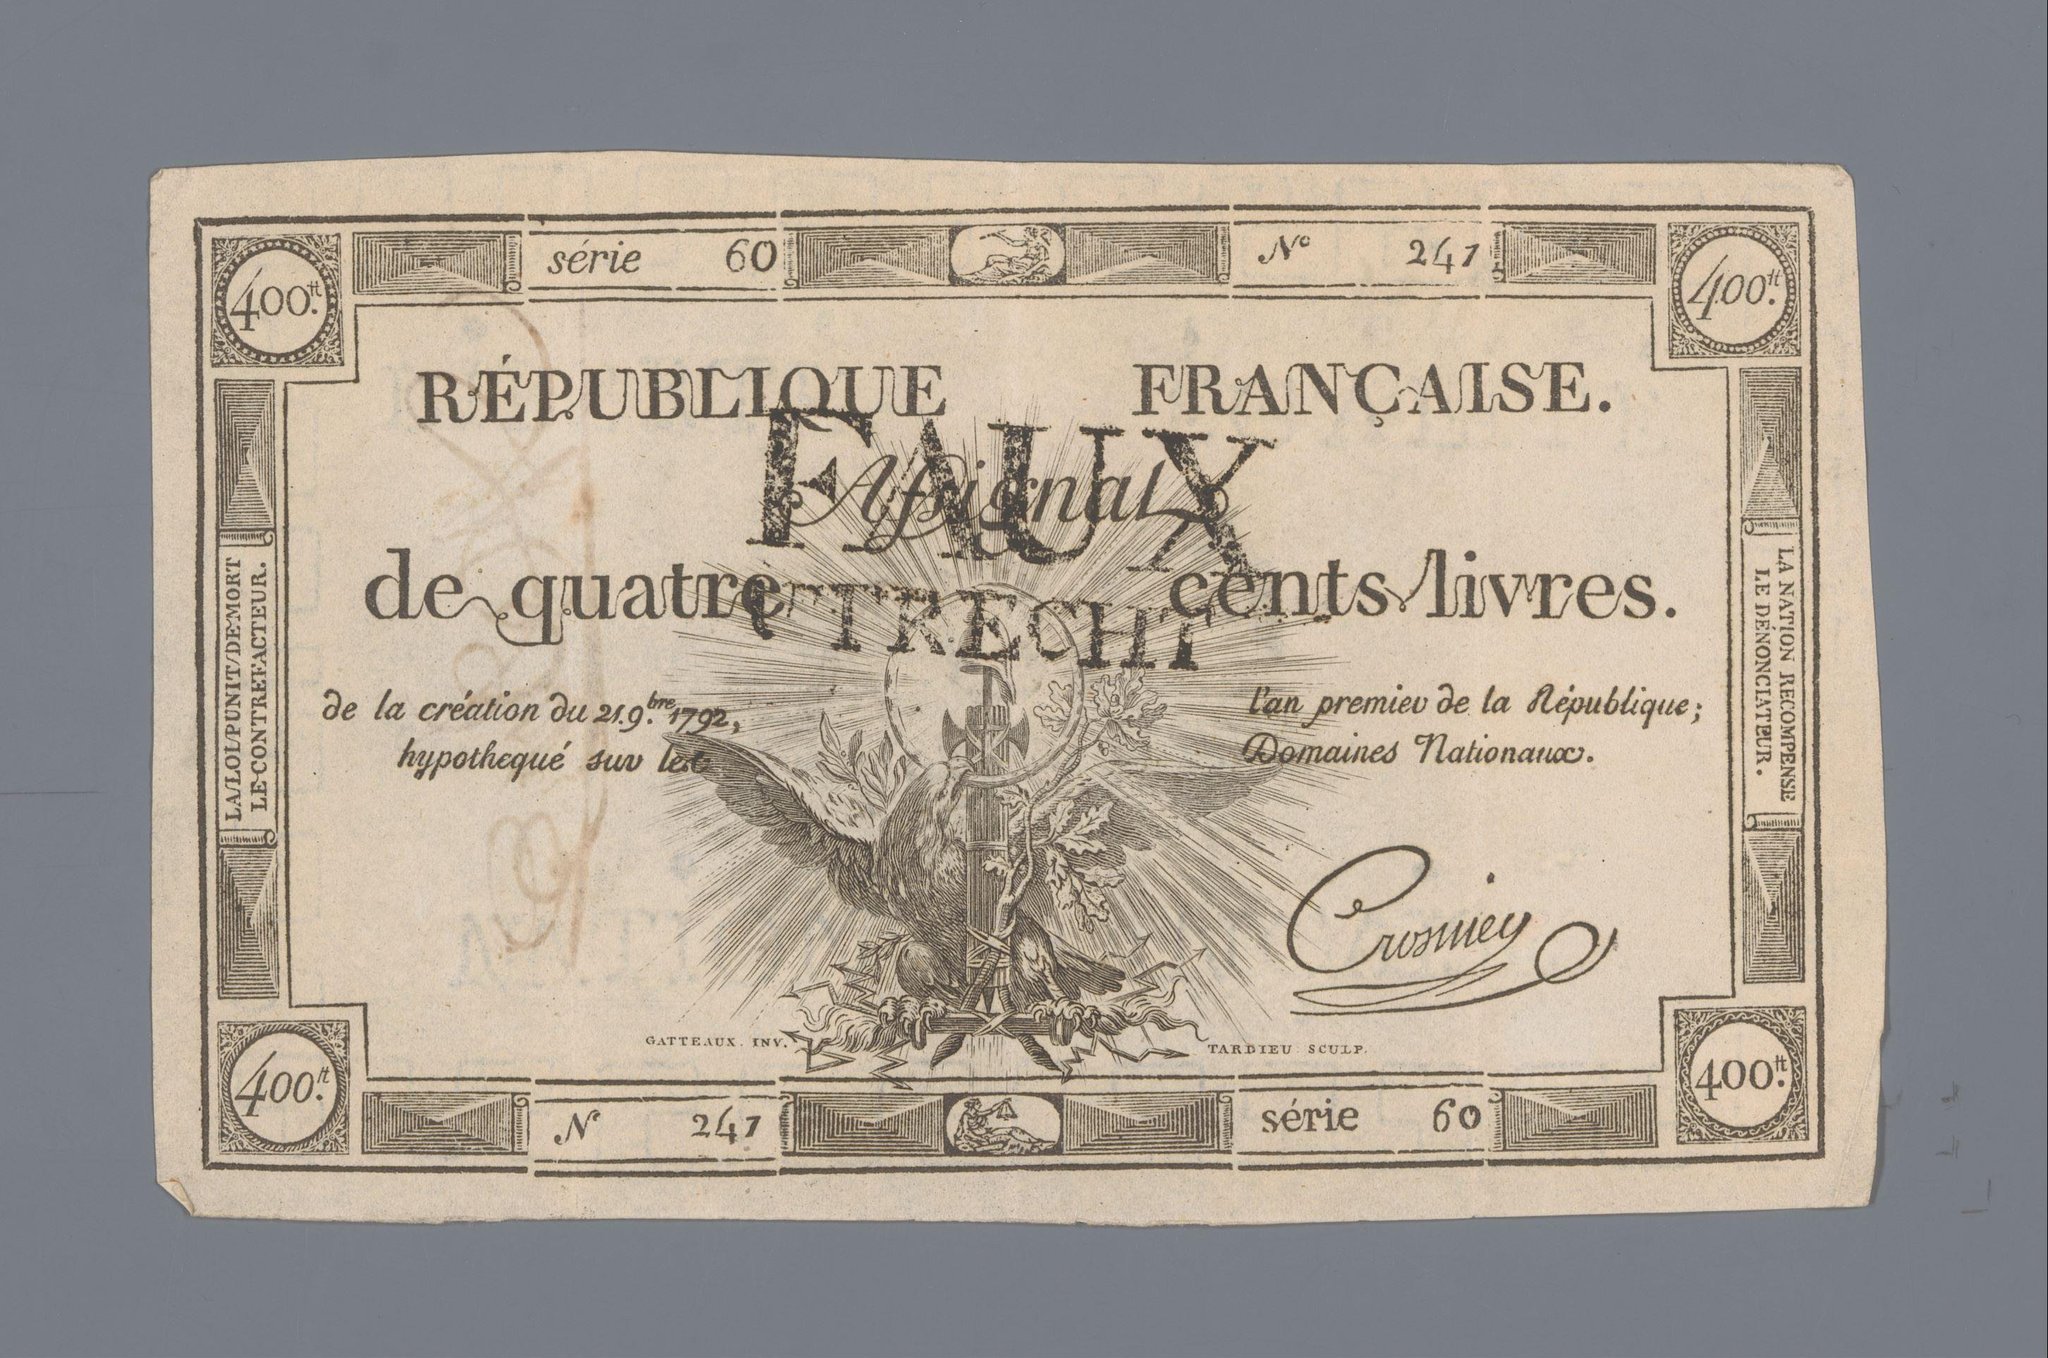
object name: assignat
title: Te Utrecht ongeldig gemaakte assignat van vierhonderd livres, serie 60, nr. 247 uitgegeven 21 november 1792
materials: paper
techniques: printing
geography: france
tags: utrecht, france